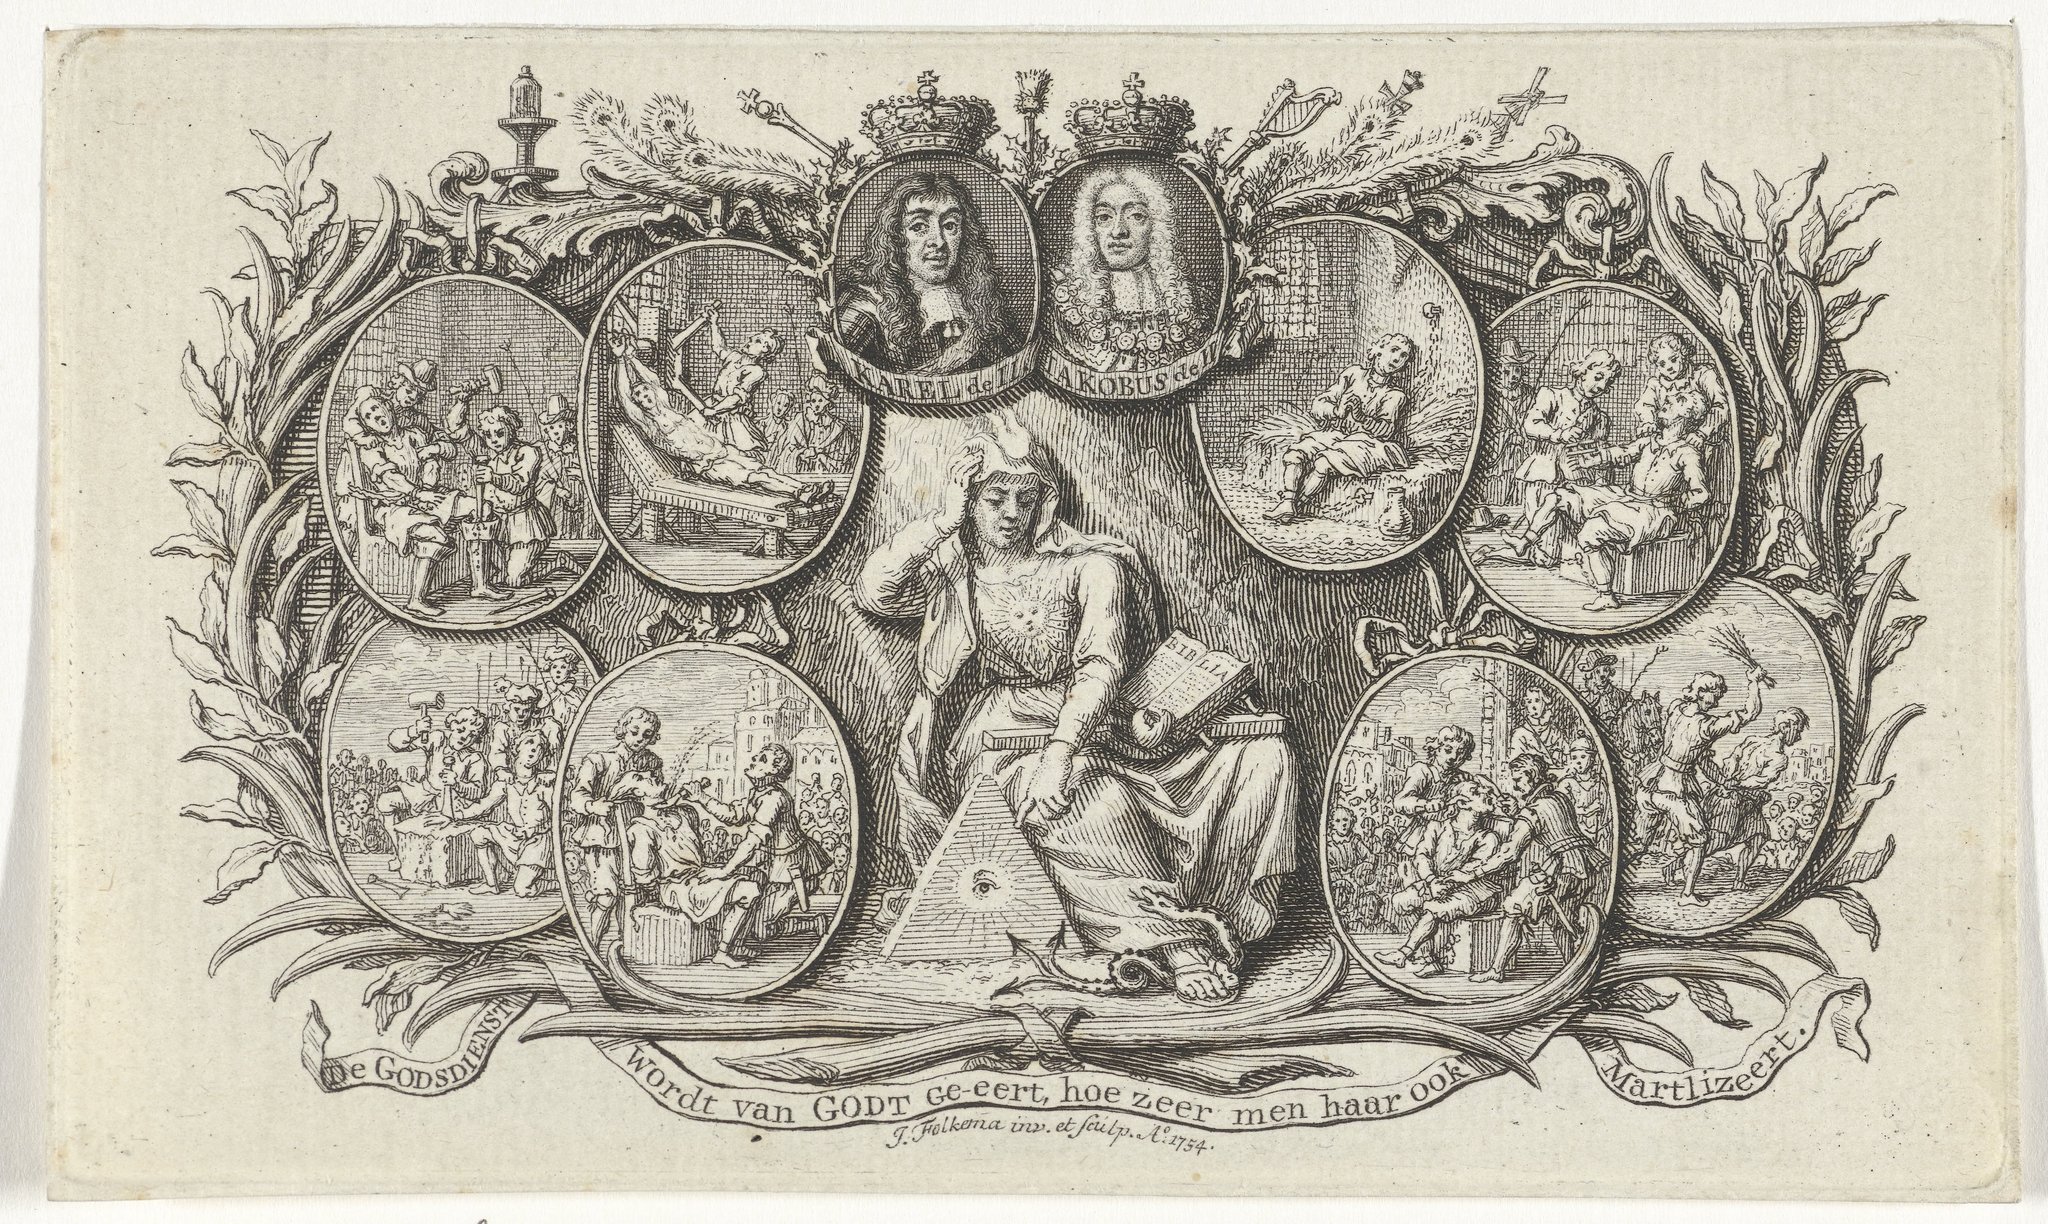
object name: print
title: Allegorie op het geloof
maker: jacob folkema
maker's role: draughtsman, print maker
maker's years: 1692-1767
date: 1702-1767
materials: paper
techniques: etching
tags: jacobus ii (koning van engeland en schotland), london, karel ii (koning van engeland), faith, 'fides'; 'fede', 'fede catholica', 'fede christiana', 'fede christiana catholica' (ripa) ~ one of the three theological virtues, torture, the all-seeing eye, triangle with eye ~ symbol of god the father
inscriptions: collector's mark: Lugt 2228, collector's mark: Lugt 2760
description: De personificatie van het geloof (Fides) zit met een kruis en een opengeslagen bijbel op schoot, haar voet staat op een slang. Boven haar hoofd wakkert een vlam, symbool van de goddelijke inspiratie. Geloof wijst op een driehoekige steen die naast haar op de grond staat waarop het Alziend Oog straalt. Boven in de voorstelling zijn twee portretmedaillons van Karel II en Jacobus II afgebeeld. Links en rechts hiervan staan acht medaillons waarop figuren op verschillende manieren gemarteld worden.